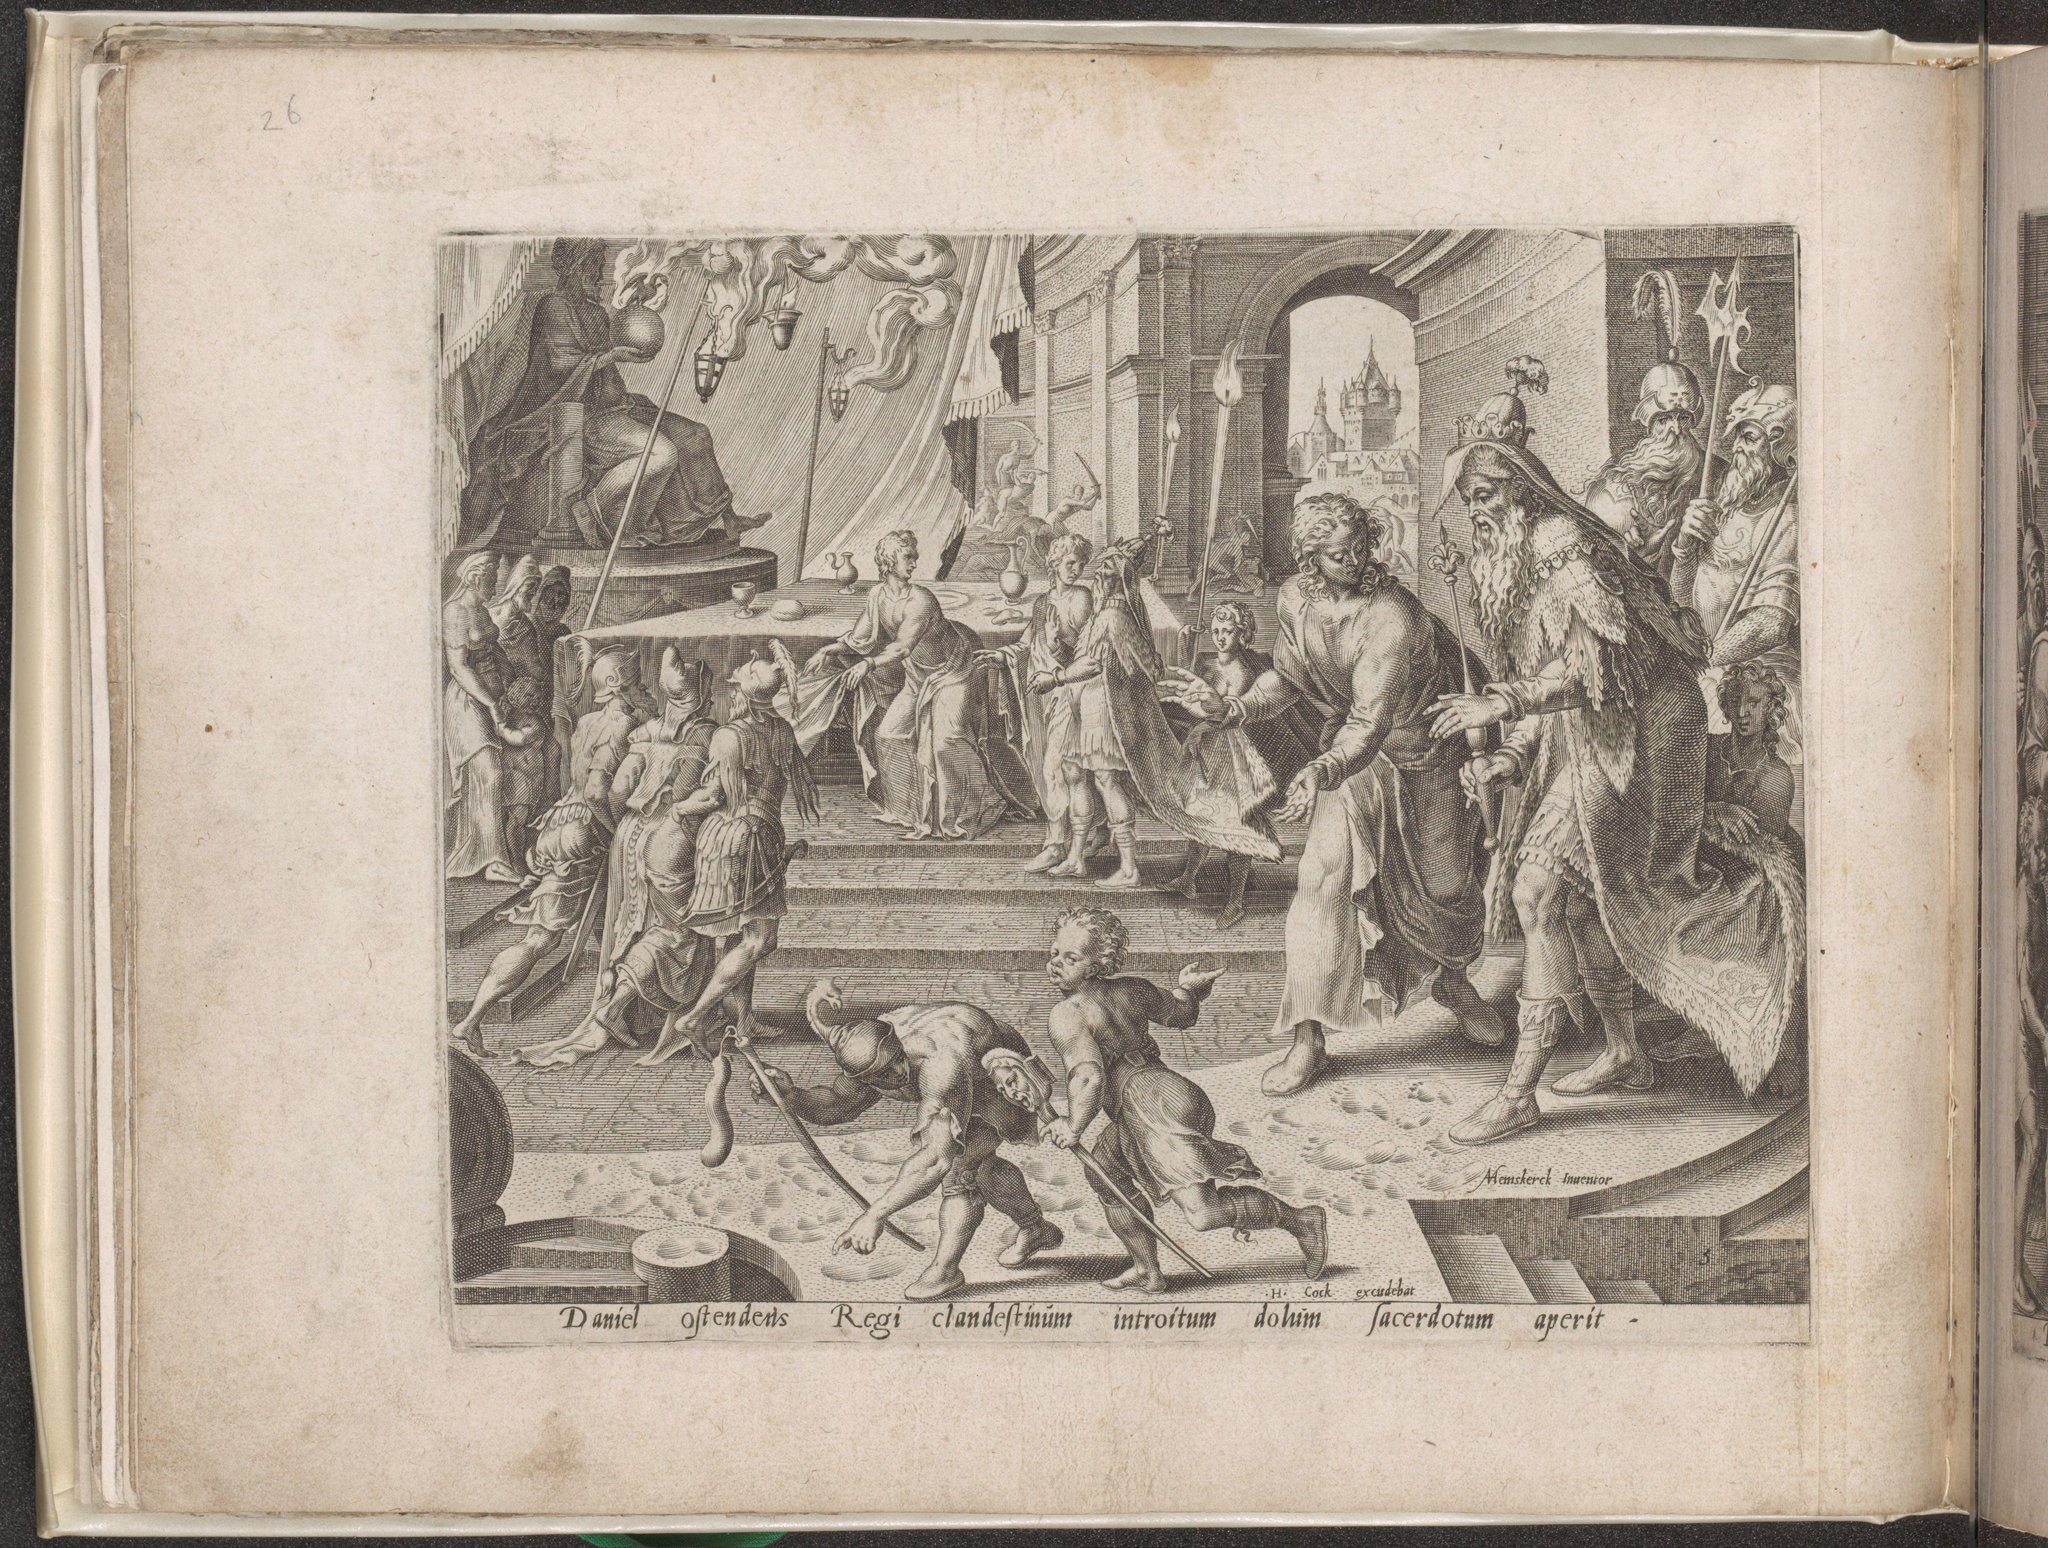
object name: album leaf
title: Geschiedenis van Daniël, Bel en de draak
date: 1565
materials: paper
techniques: engraving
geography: antwerp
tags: the priests of bel and their relatives are arrested; they are put to death afterwards, daniel shows king cyrus the footprints of the priests of bel and their relatives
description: Koning Cyrus en Daniël komen 's ochtends naar de tempel en zien voetsporen in de as die Daniël over de vloer heeft gestrooid. Ze ontdekken de geheime ingang tot de tempel, waardoor de priesters en hun families zijn binnengekomen om het eten van Bel op te eten. Onder de voorstelling een verklarende tekst in het Latijn. Deze prent maakt deel uit van een album.